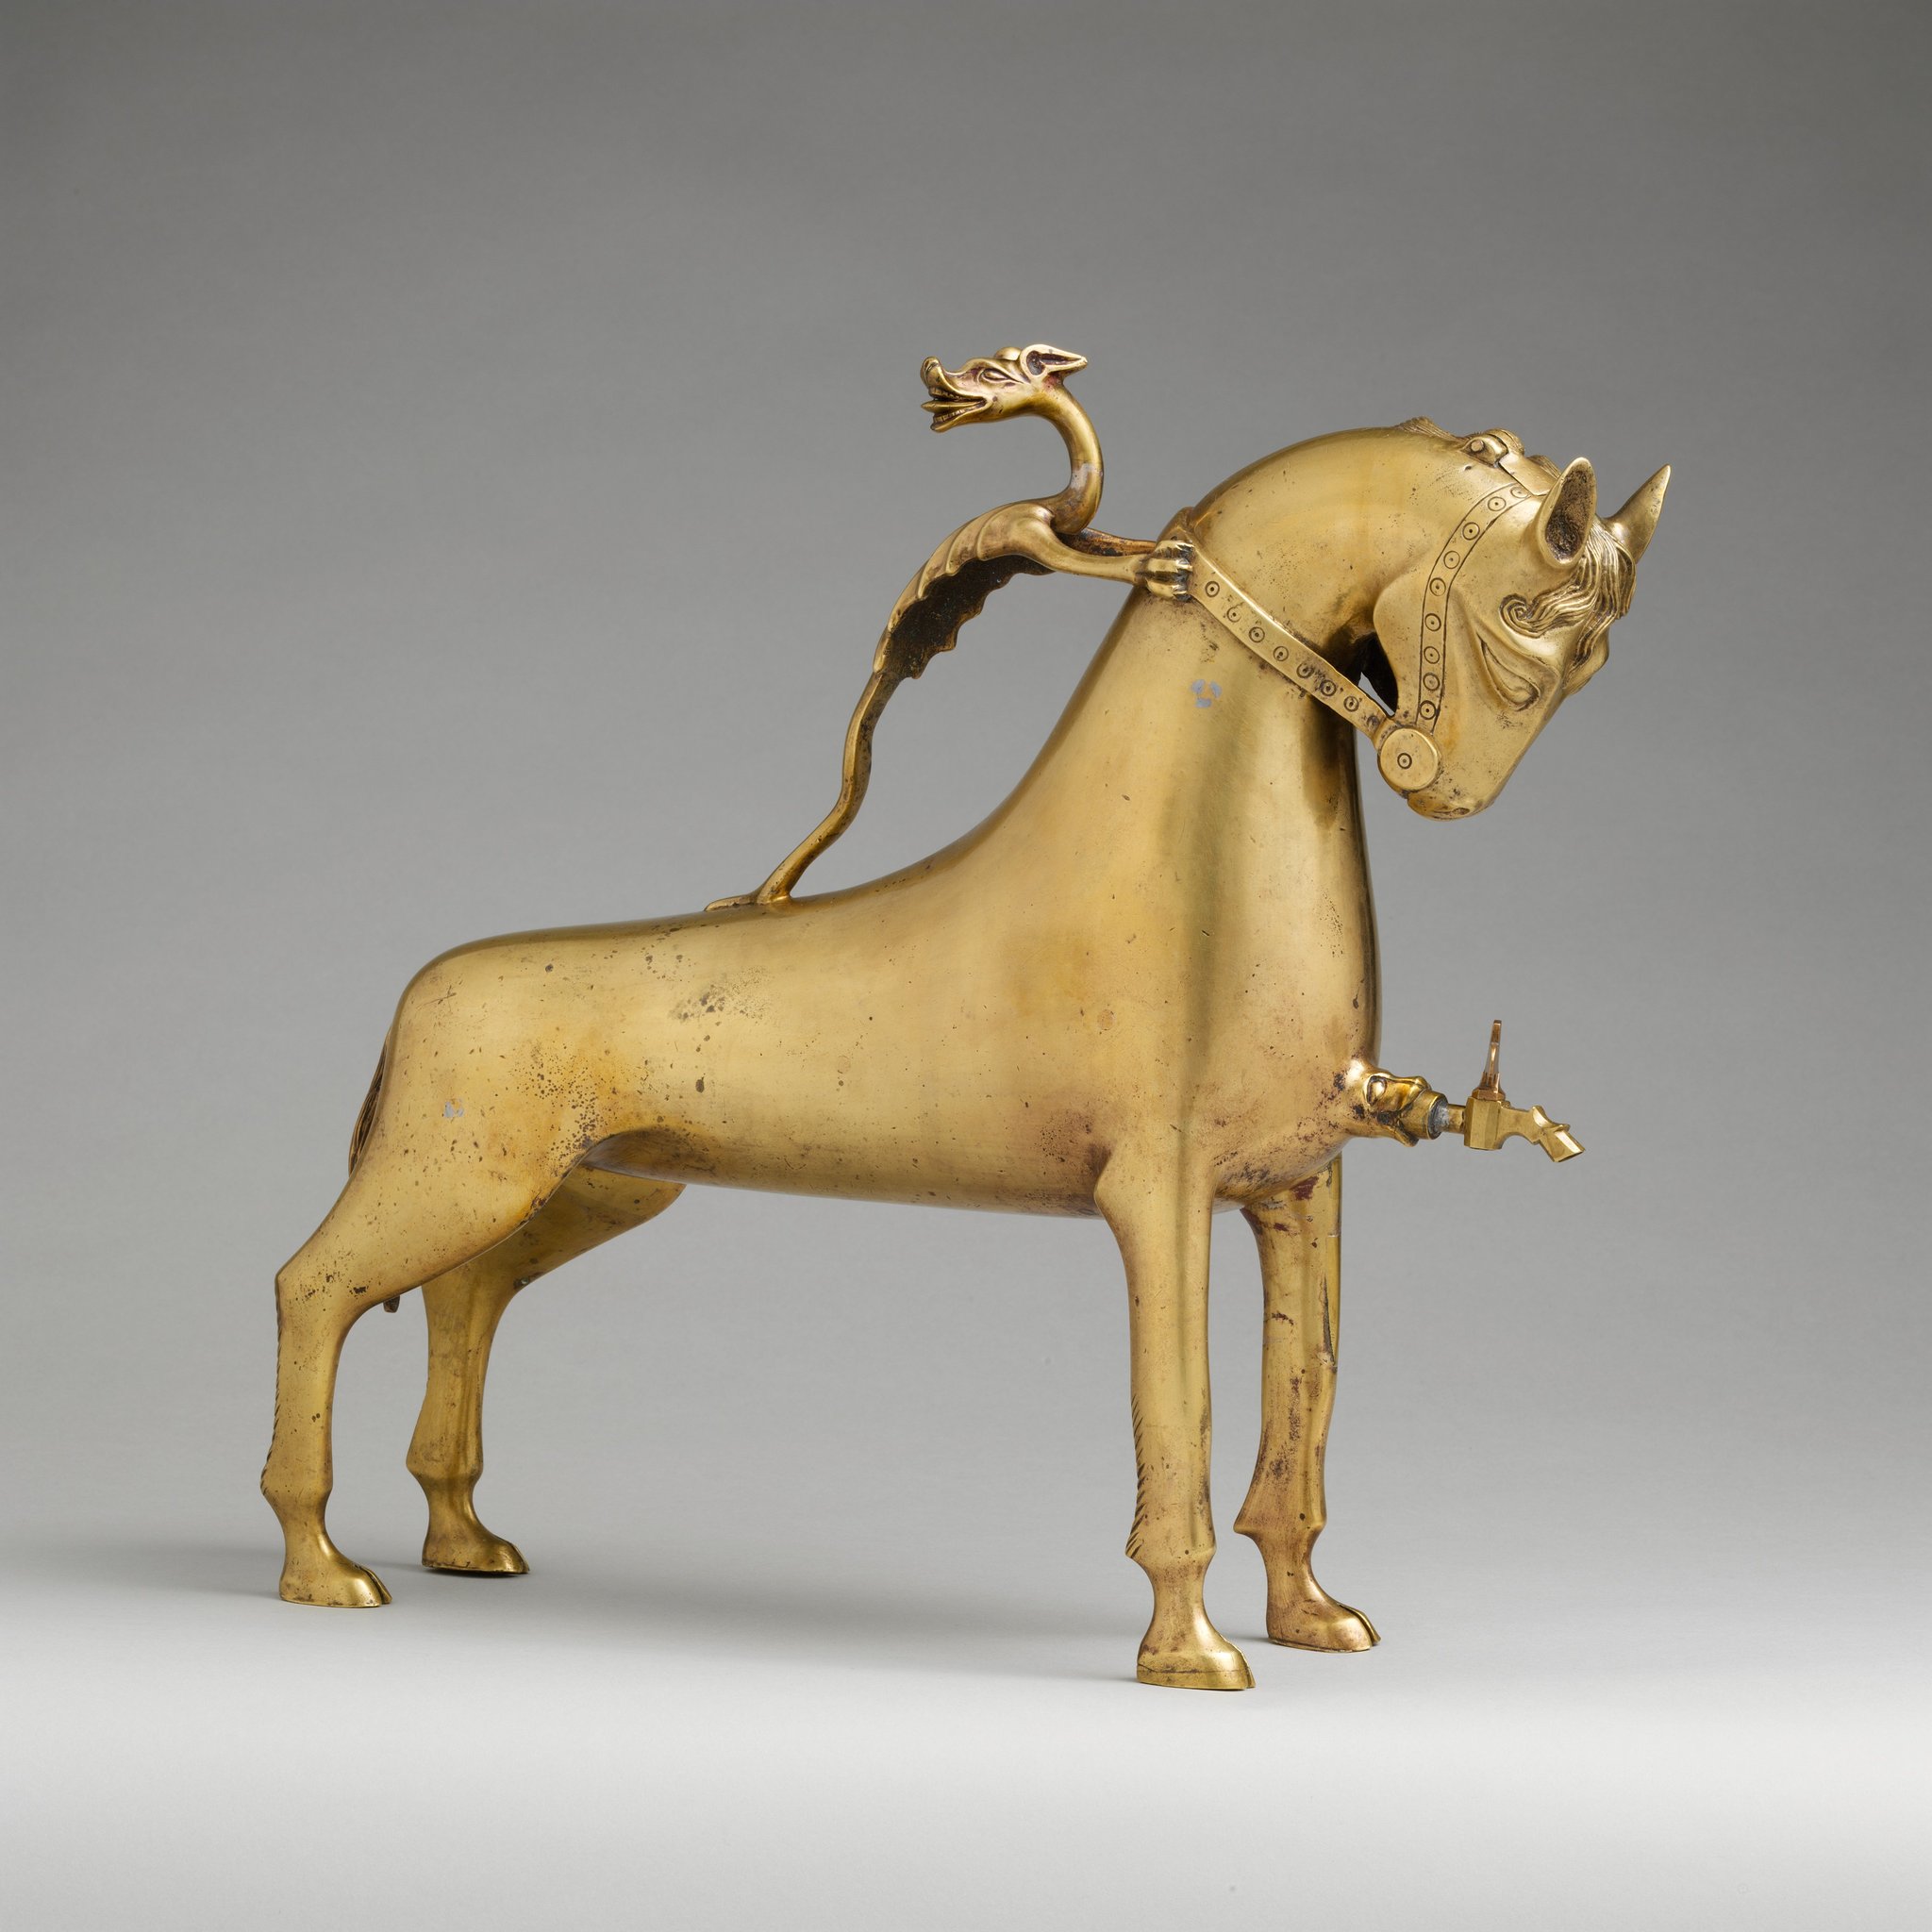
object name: aquamanile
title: Aquamanile in the Form of a Horse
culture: german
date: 1400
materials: copper alloy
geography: nuremberg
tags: horses